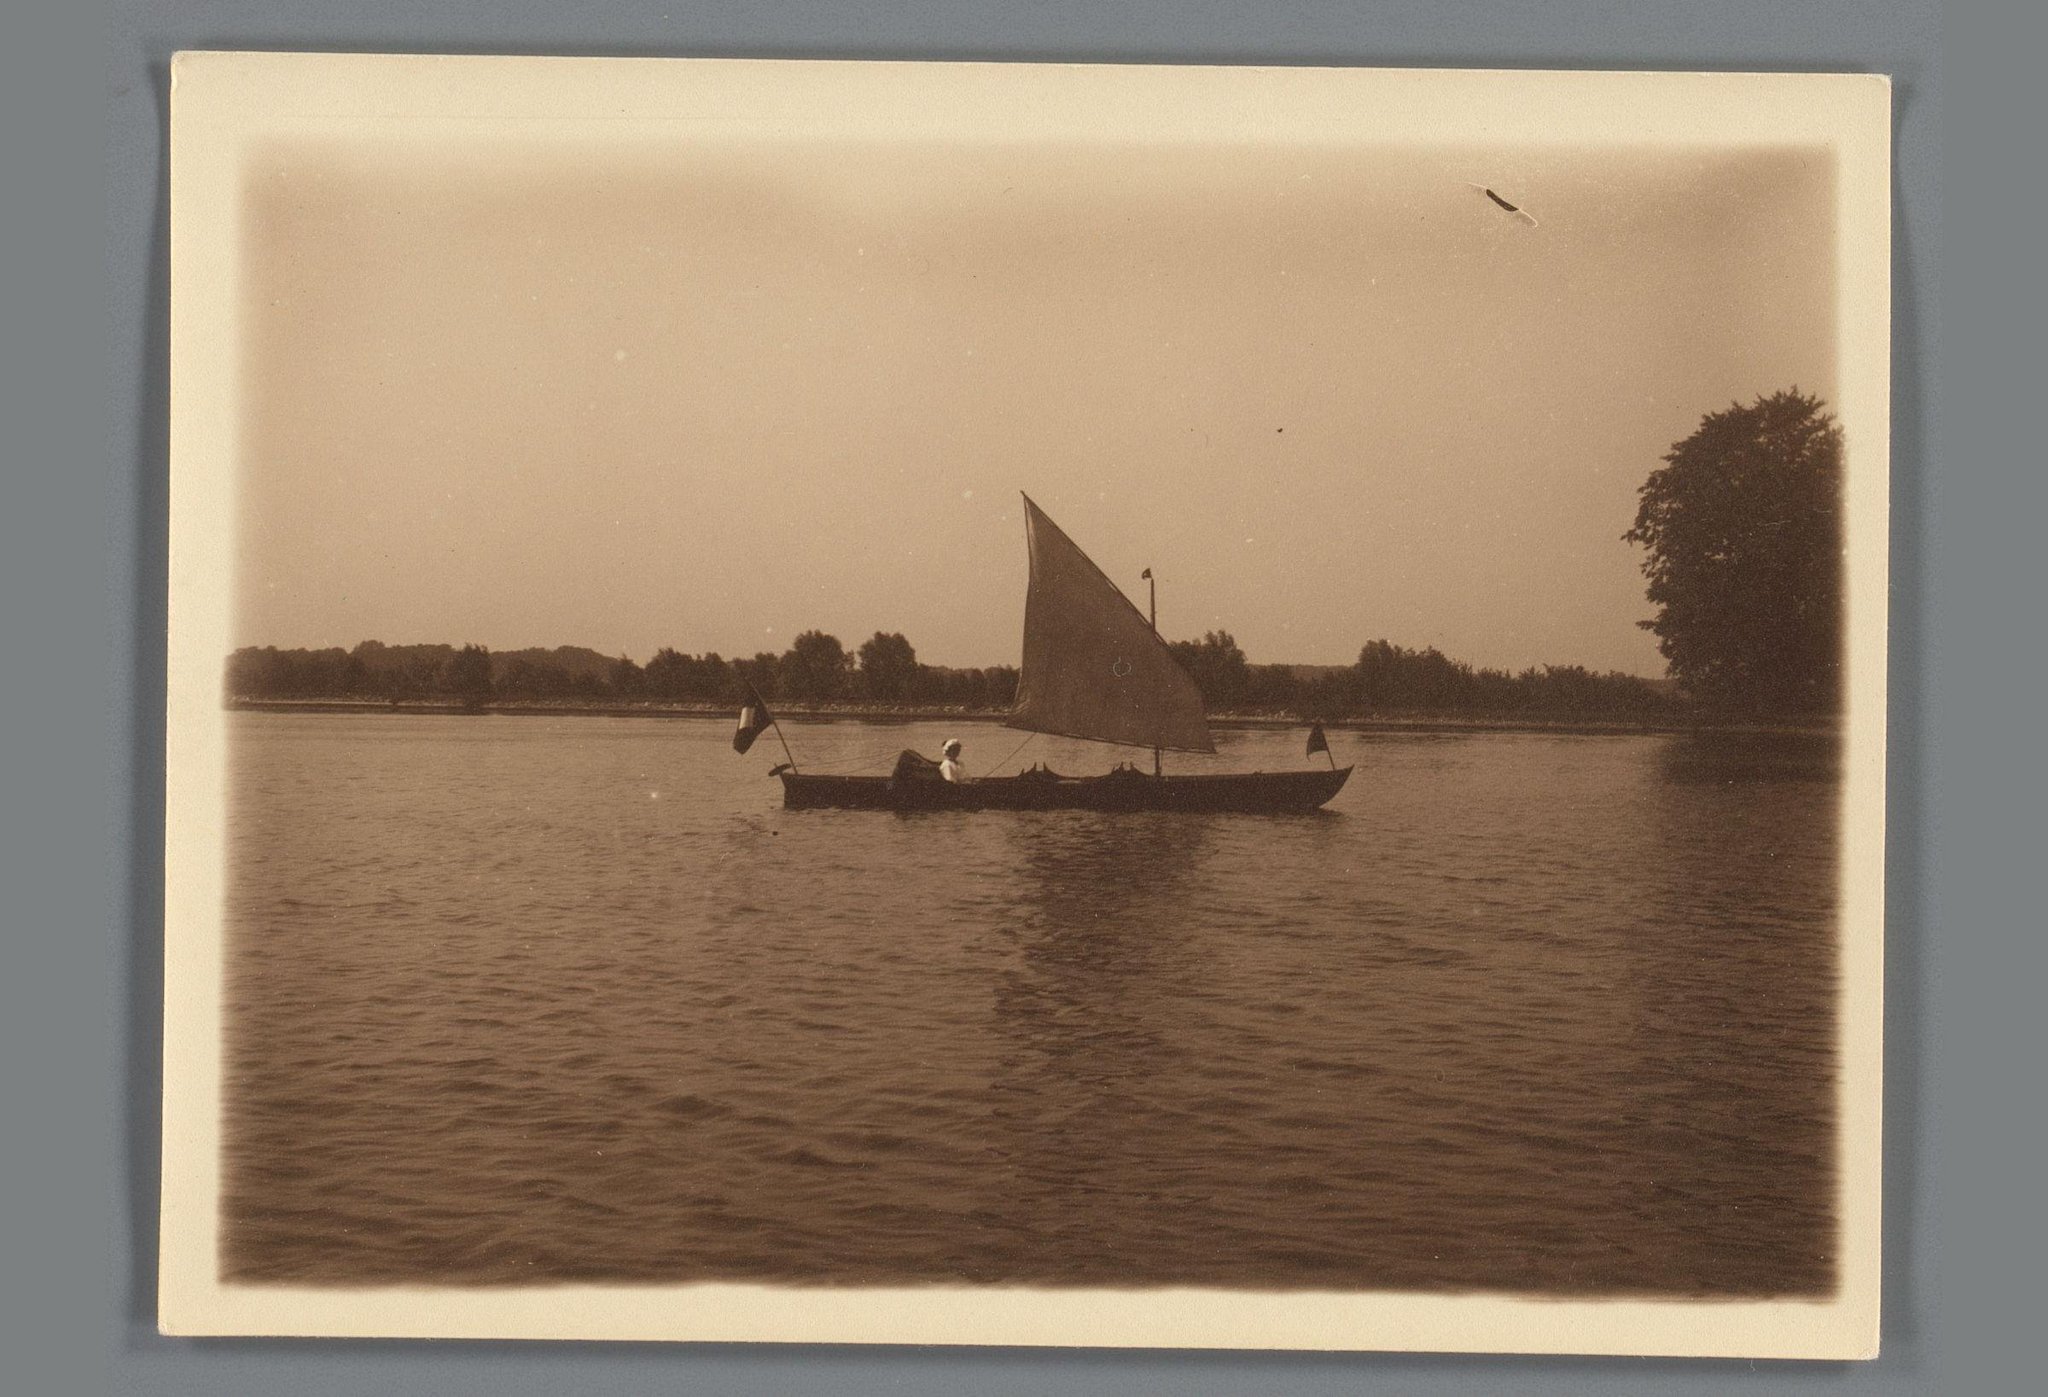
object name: photograph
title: Zeilboot op de Amstel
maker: Anonymous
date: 1916-1918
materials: paper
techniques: matte daylight collodion silver print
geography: amstel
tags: sailing-ship, sailing-boat, river